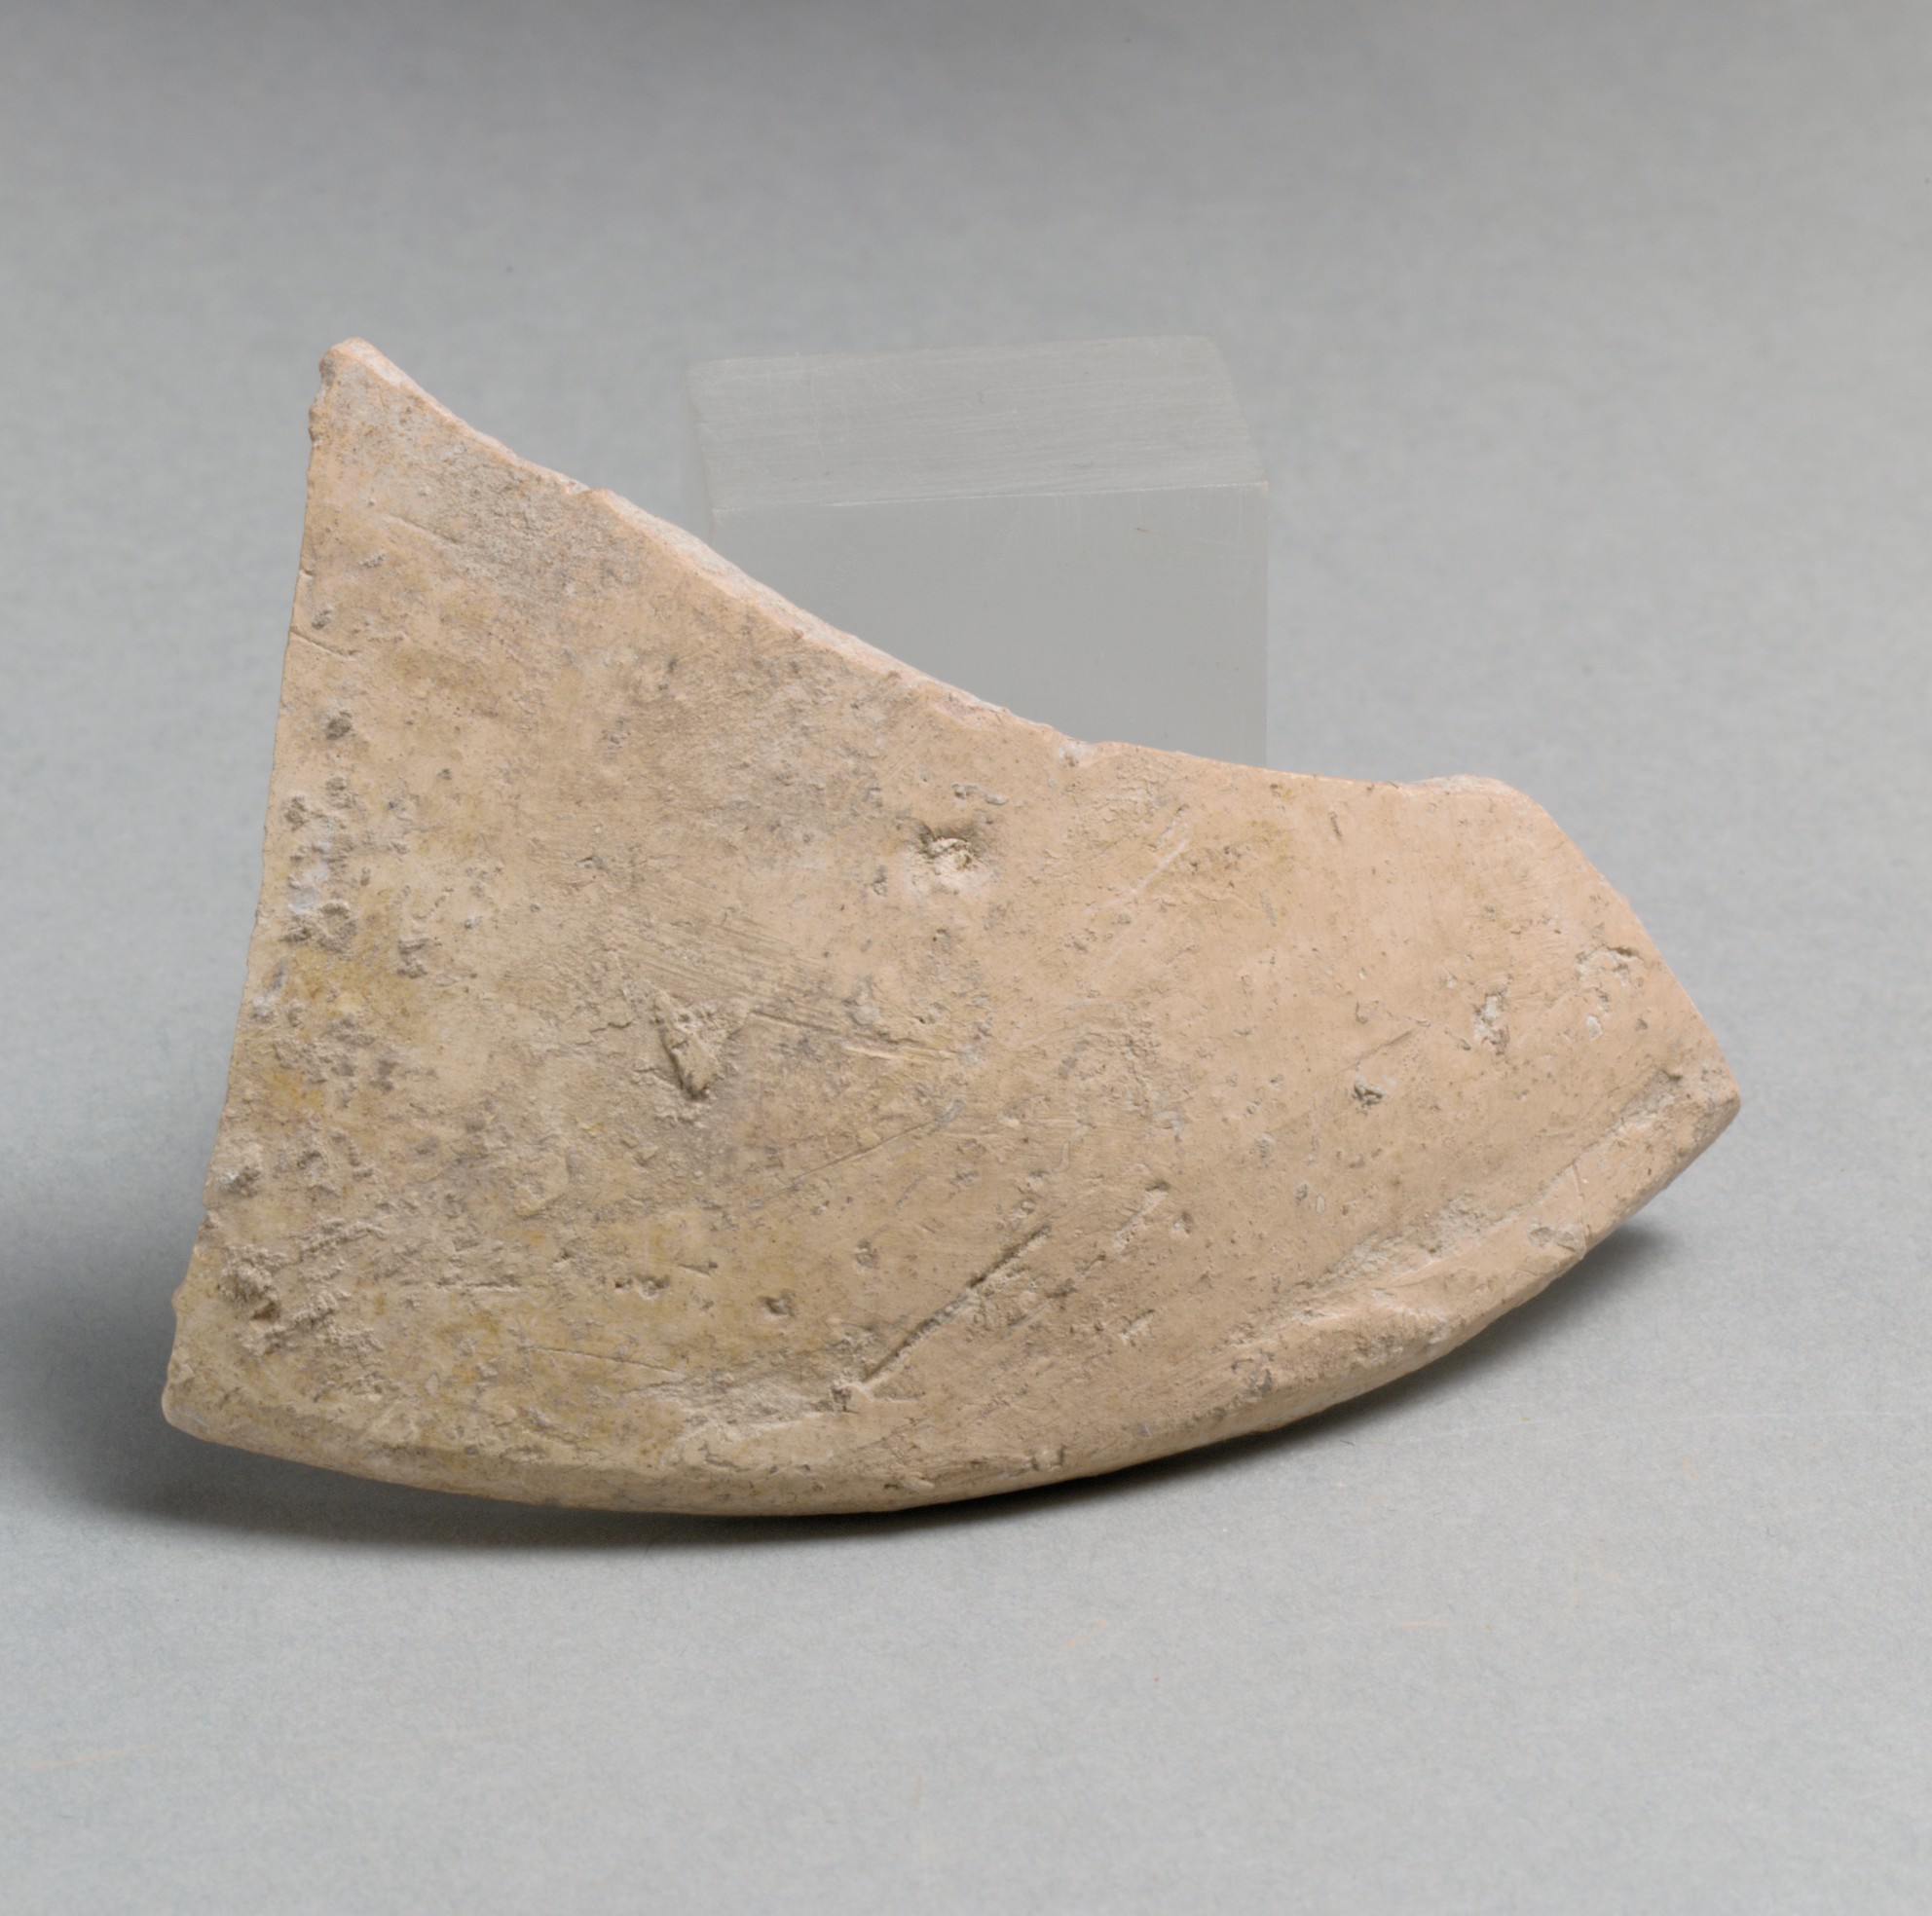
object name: vase fragment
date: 3000-2200 BCE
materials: terracotta